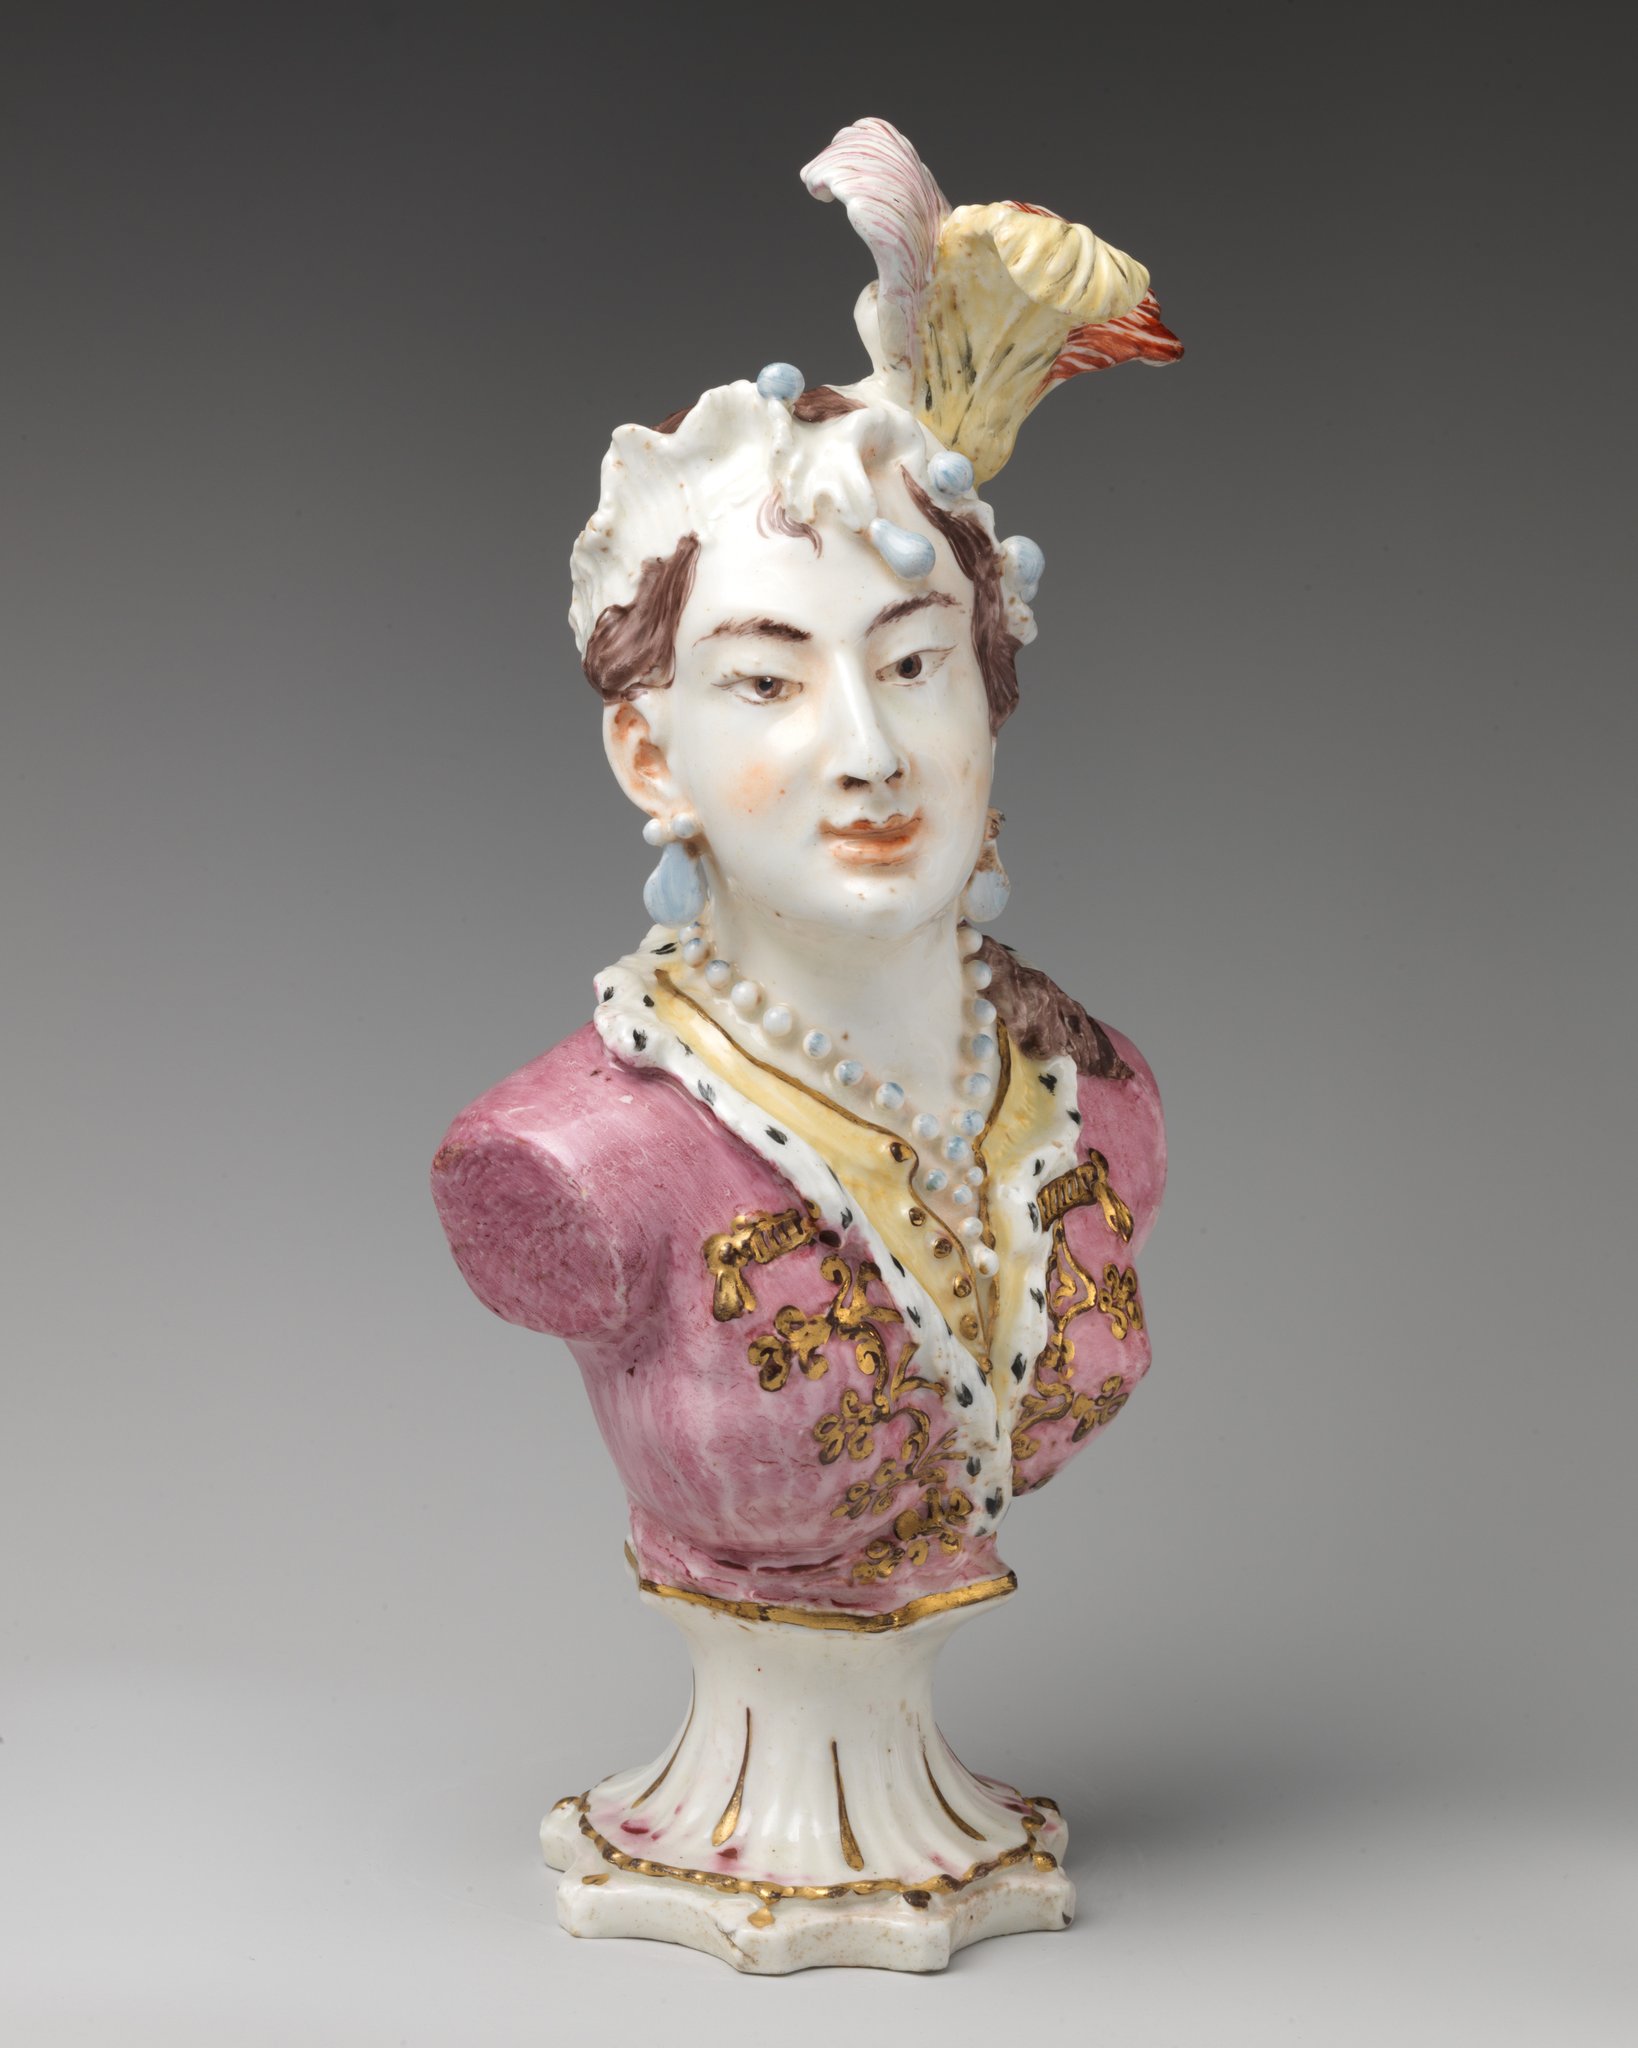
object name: figure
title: A Mongolian lady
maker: bow porcelain factory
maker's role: factory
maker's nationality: british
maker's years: 1747-1776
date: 1750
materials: soft paste porcelain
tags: men,women